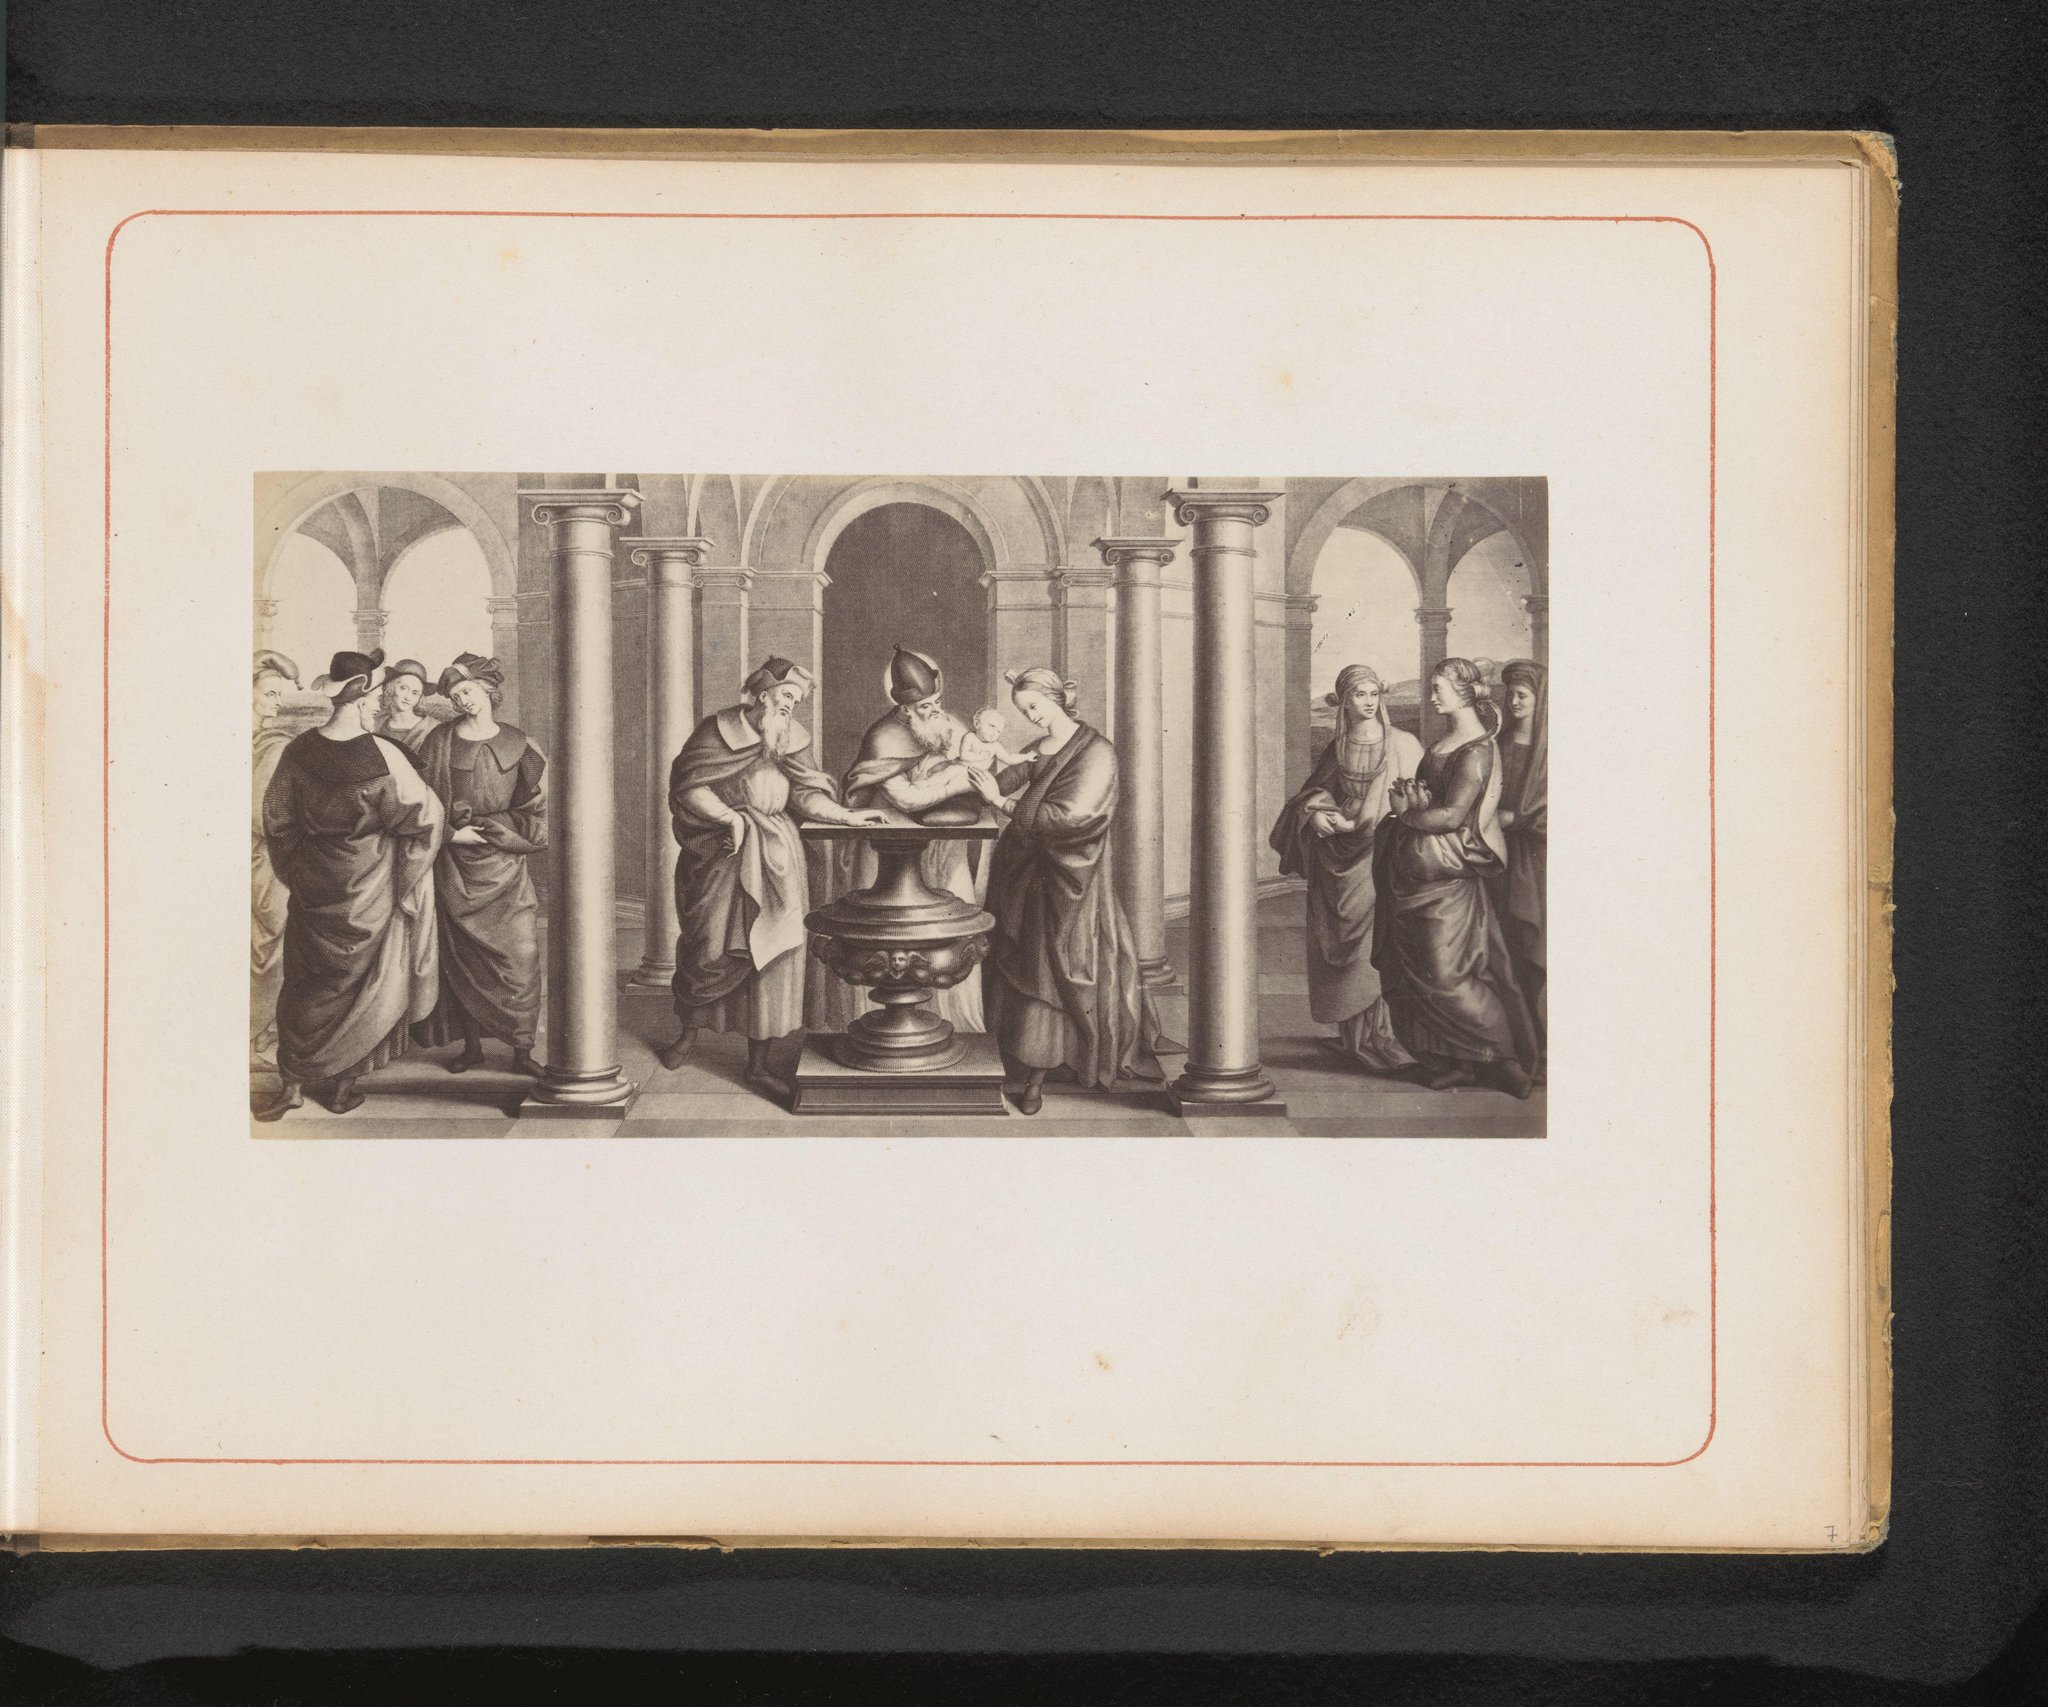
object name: photograph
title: Fotoreproductie van een gravure naar De presentatie in de tempel door Rafaël in het Vaticaan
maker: Anonymous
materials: photographic support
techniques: albumen print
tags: presentation of the christ-child in the temple, usually simeon (and anna) present (luke 2:22-39)